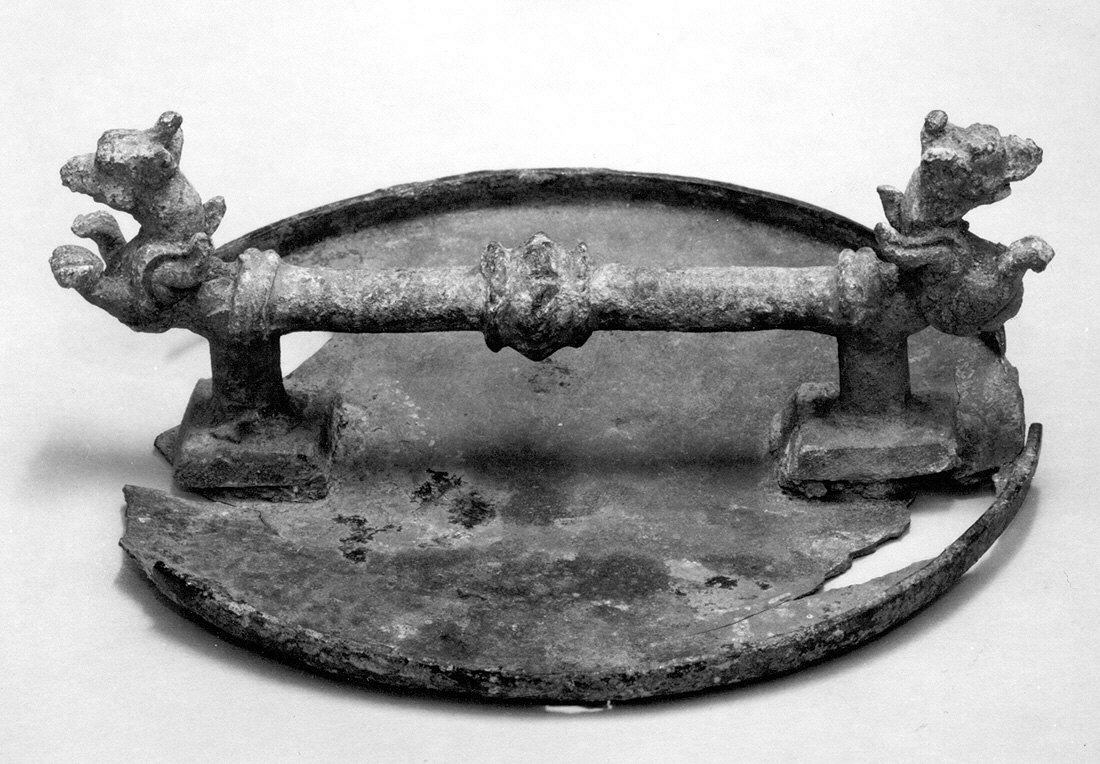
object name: mirror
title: Mirror with a handle terminating in griffins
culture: parthian or sasanian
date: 201-400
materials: bronze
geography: central asia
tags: griffins